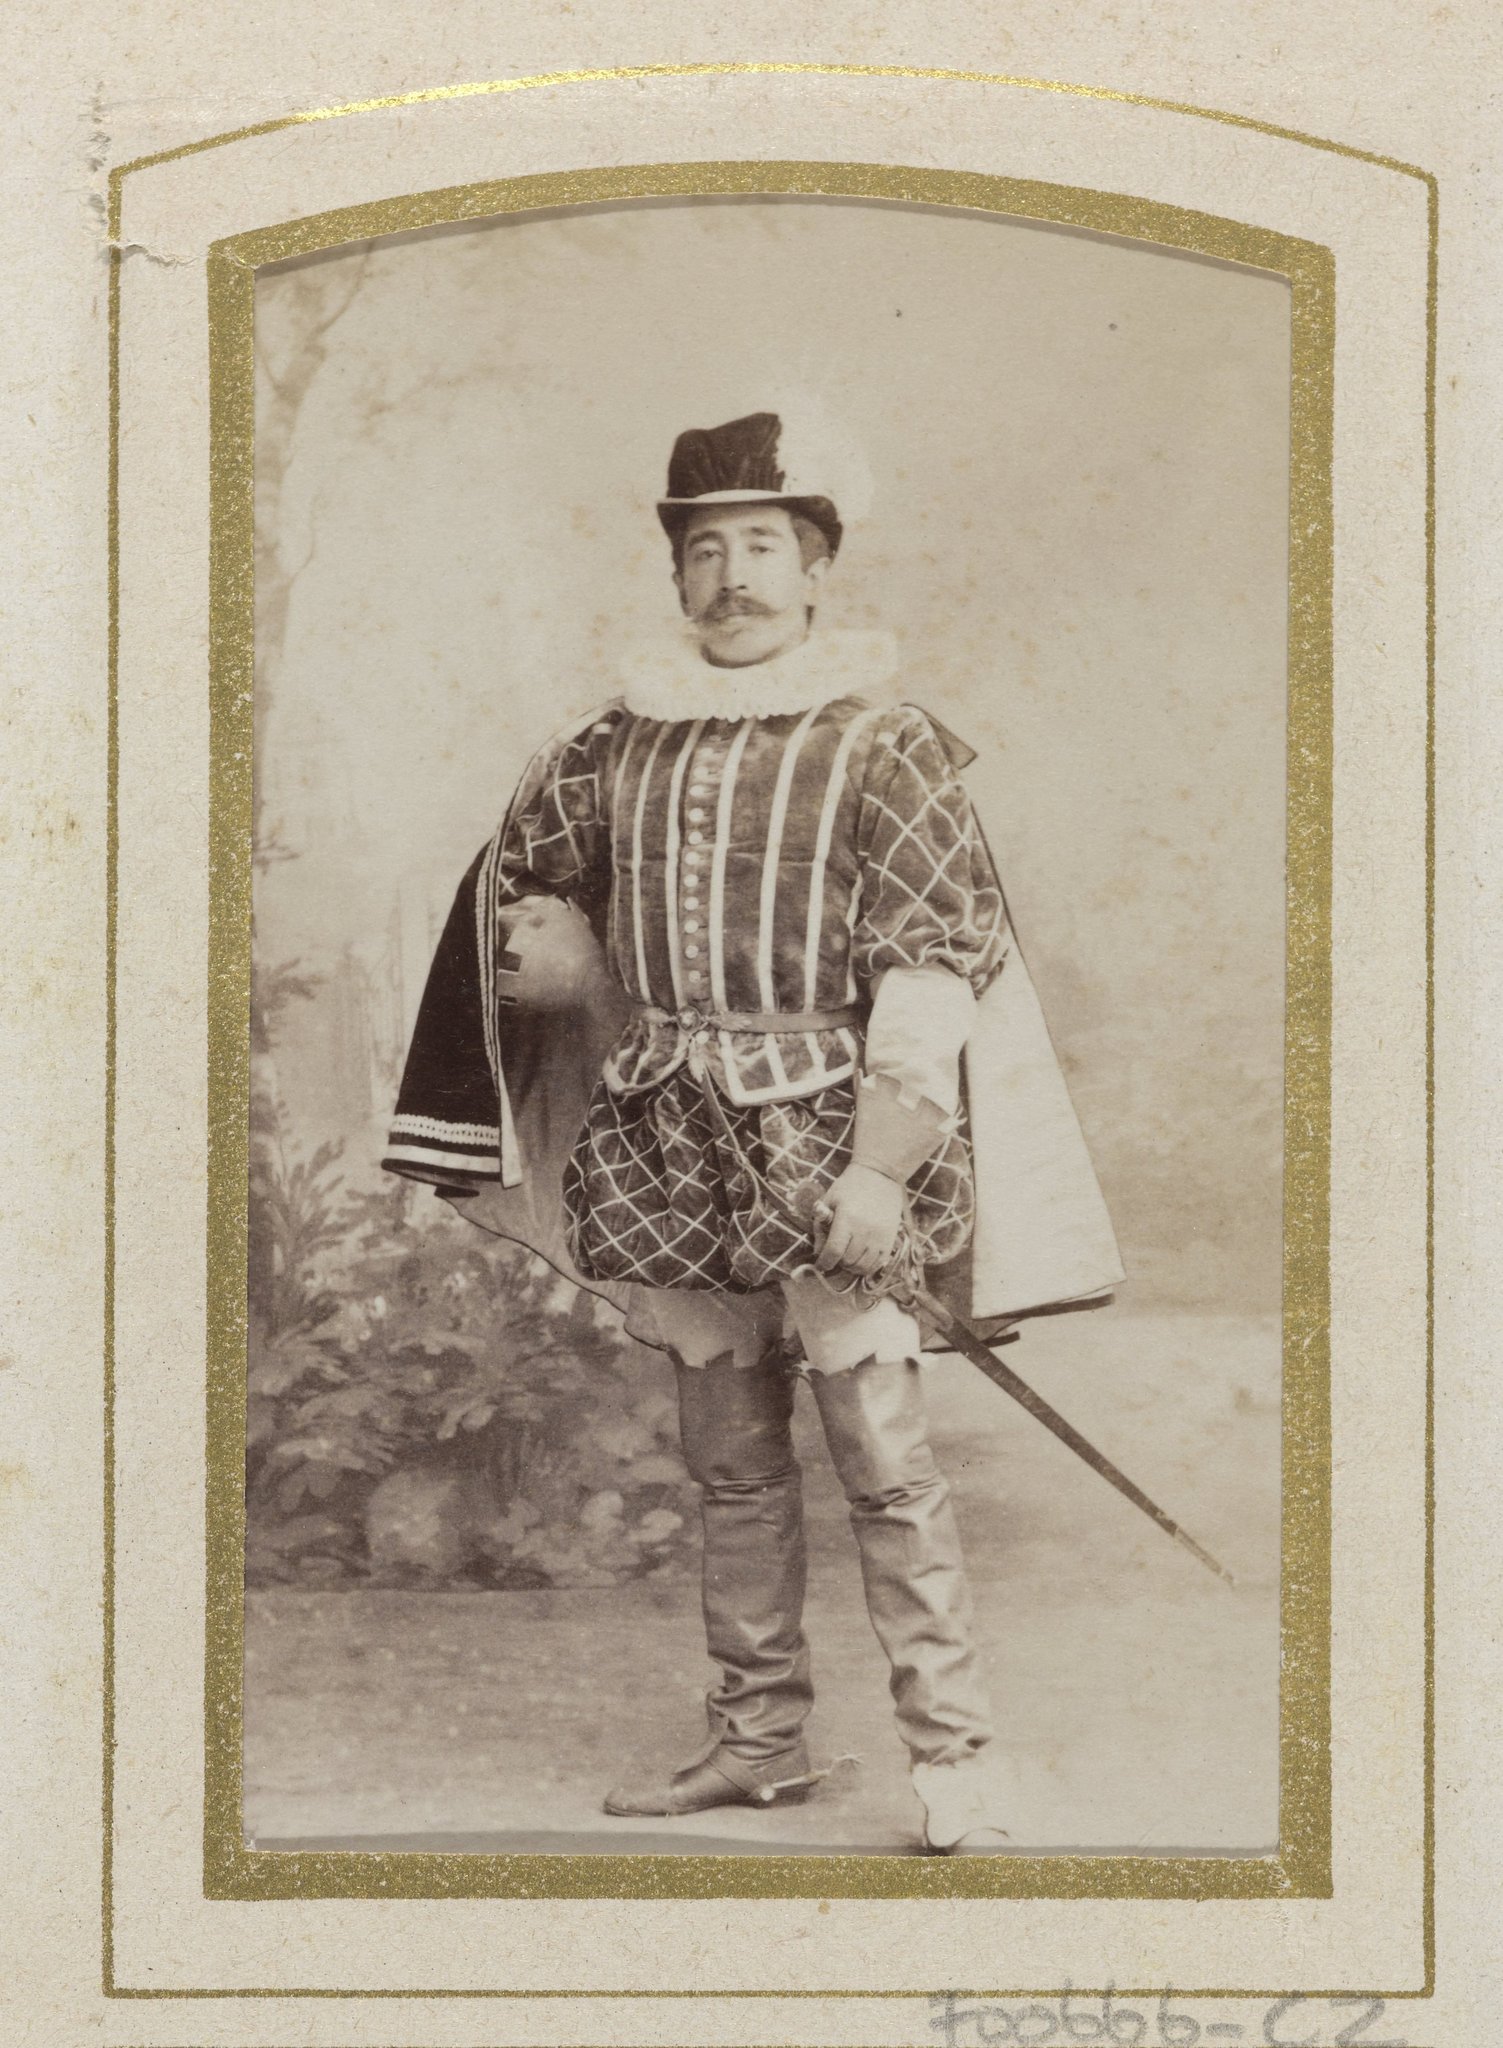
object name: album leaf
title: Portret van een jonge man in kostuum met zwaard, aangeduid als W. Birnie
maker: antonius joannes van der stok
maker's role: fotograaf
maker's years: 1862-1941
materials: cardboard, photographic support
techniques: albumen print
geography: leiden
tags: historical persons, hacking and thrusting weapons: sword, historical costume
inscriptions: inscription: ‘Ant. J. van der Stok/ PHOTOGRAPHE/ Leiden Rapenburg 13.’, name: ‘W. Birnie 249.’